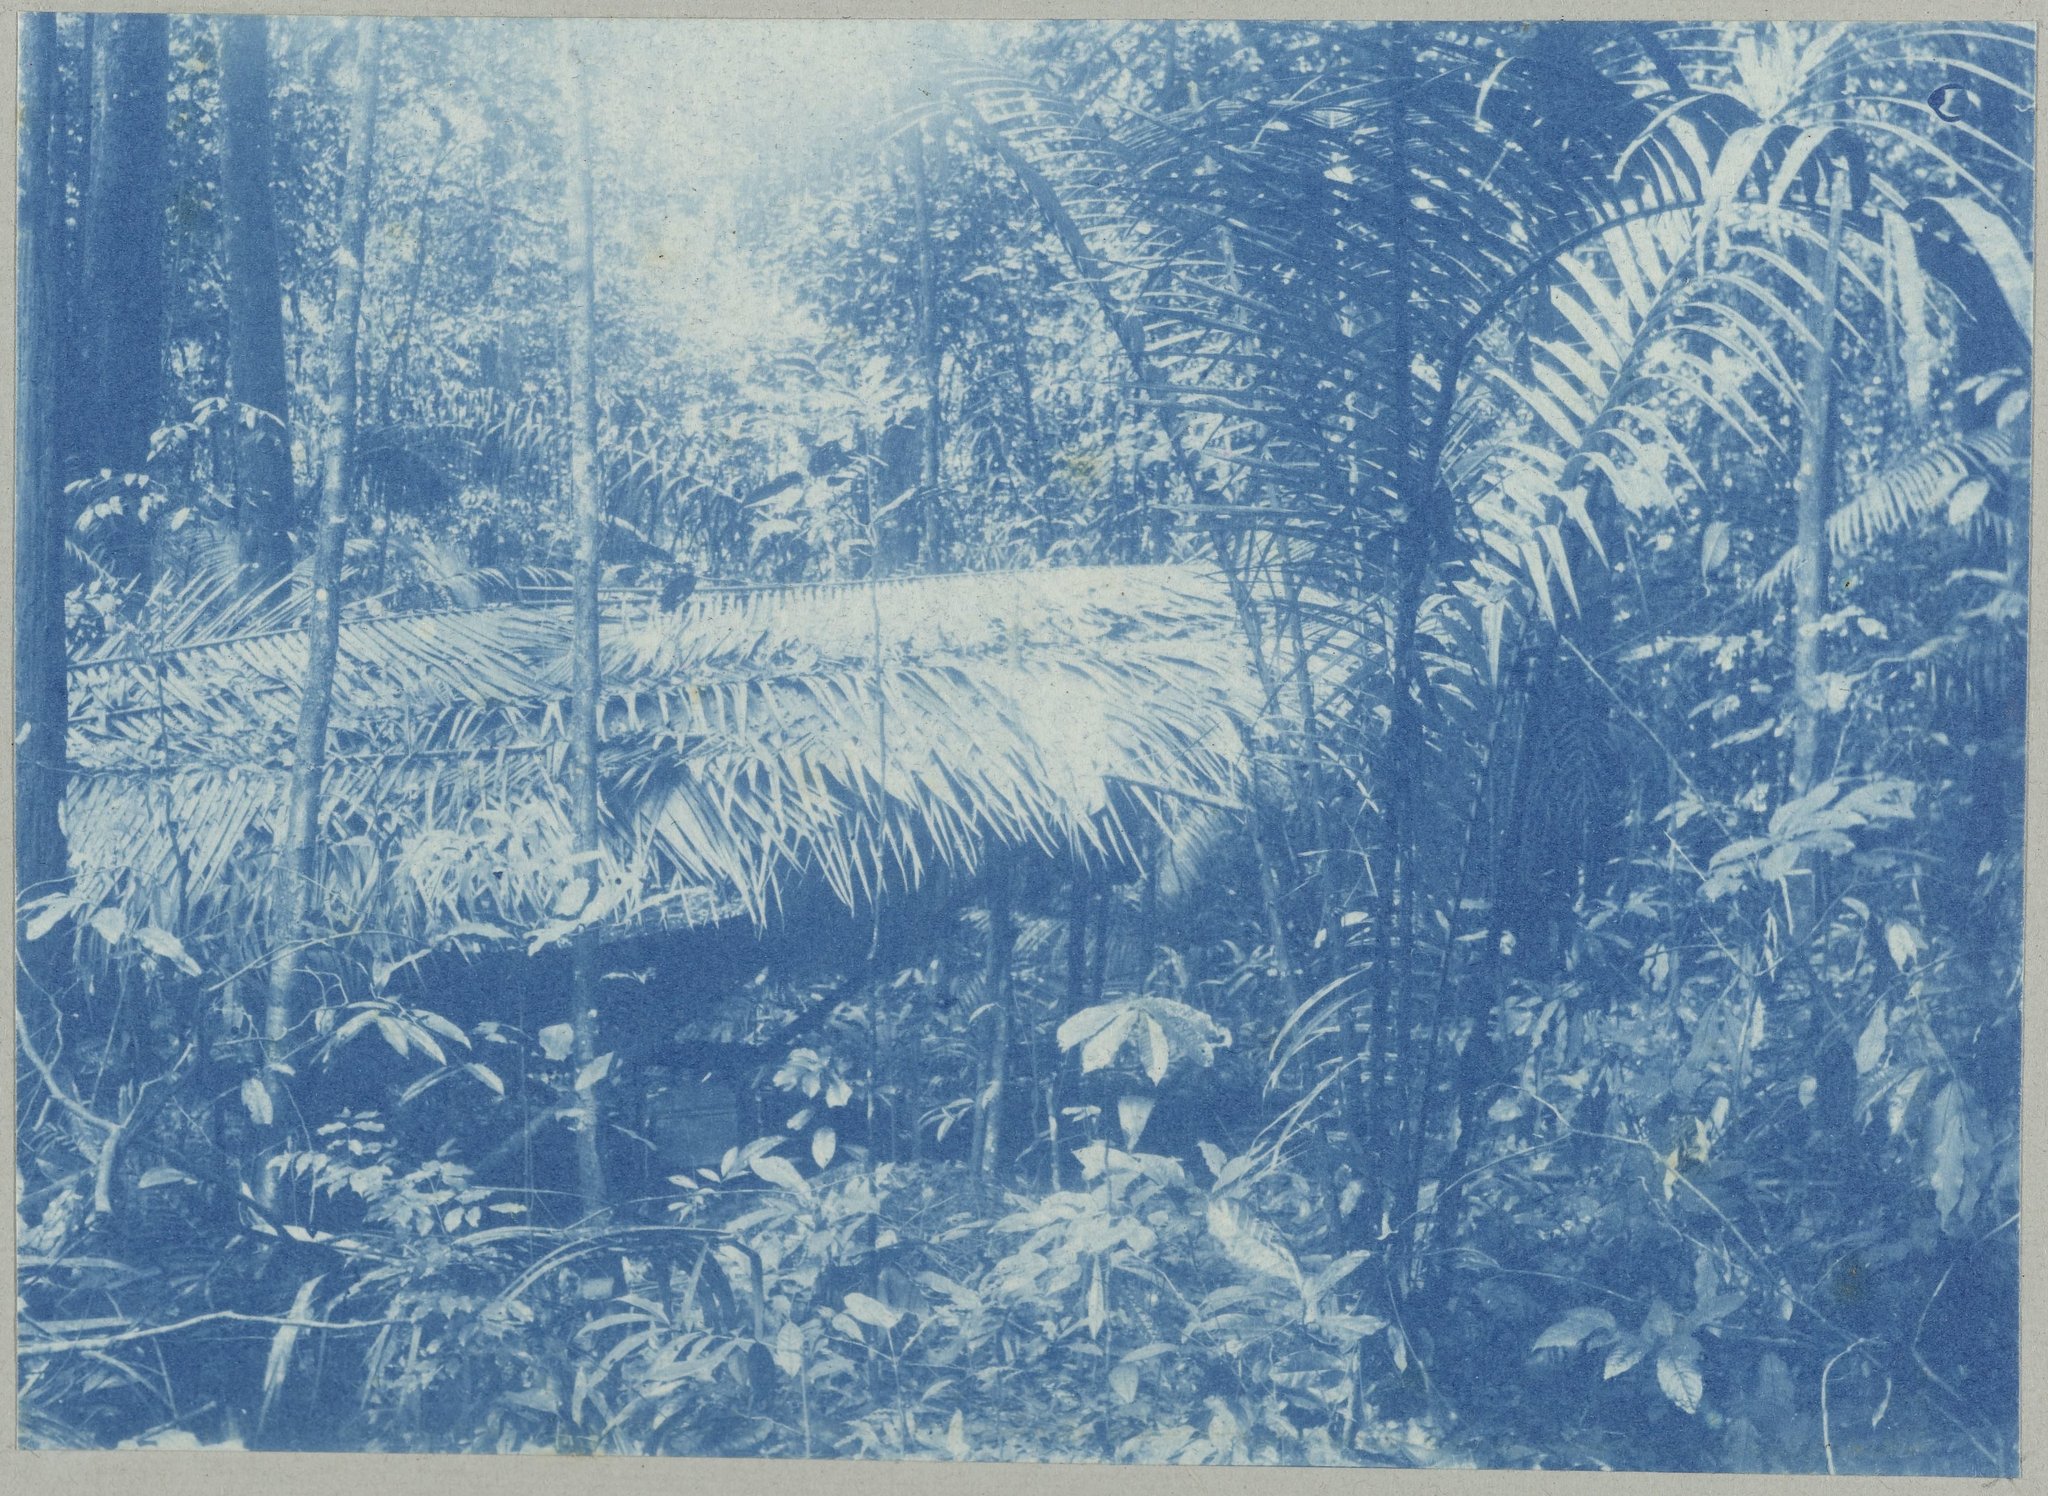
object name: photograph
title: Meetkamp in oerbosch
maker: hendrik doijer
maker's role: engineer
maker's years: 1863-1925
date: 1903-1910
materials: photographic support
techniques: cyanotype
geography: suriname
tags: suriname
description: Gezicht op een hut gebouwd van takken en bladeren in het meetkamp, in het oerwoud. Onderdeel van het fotoalbum Souvenir de Voyage (deel 1), over het leven van de familie Doijer in en rond de plantage Ma Retraite in Suriname in de jaren 1903-1910.